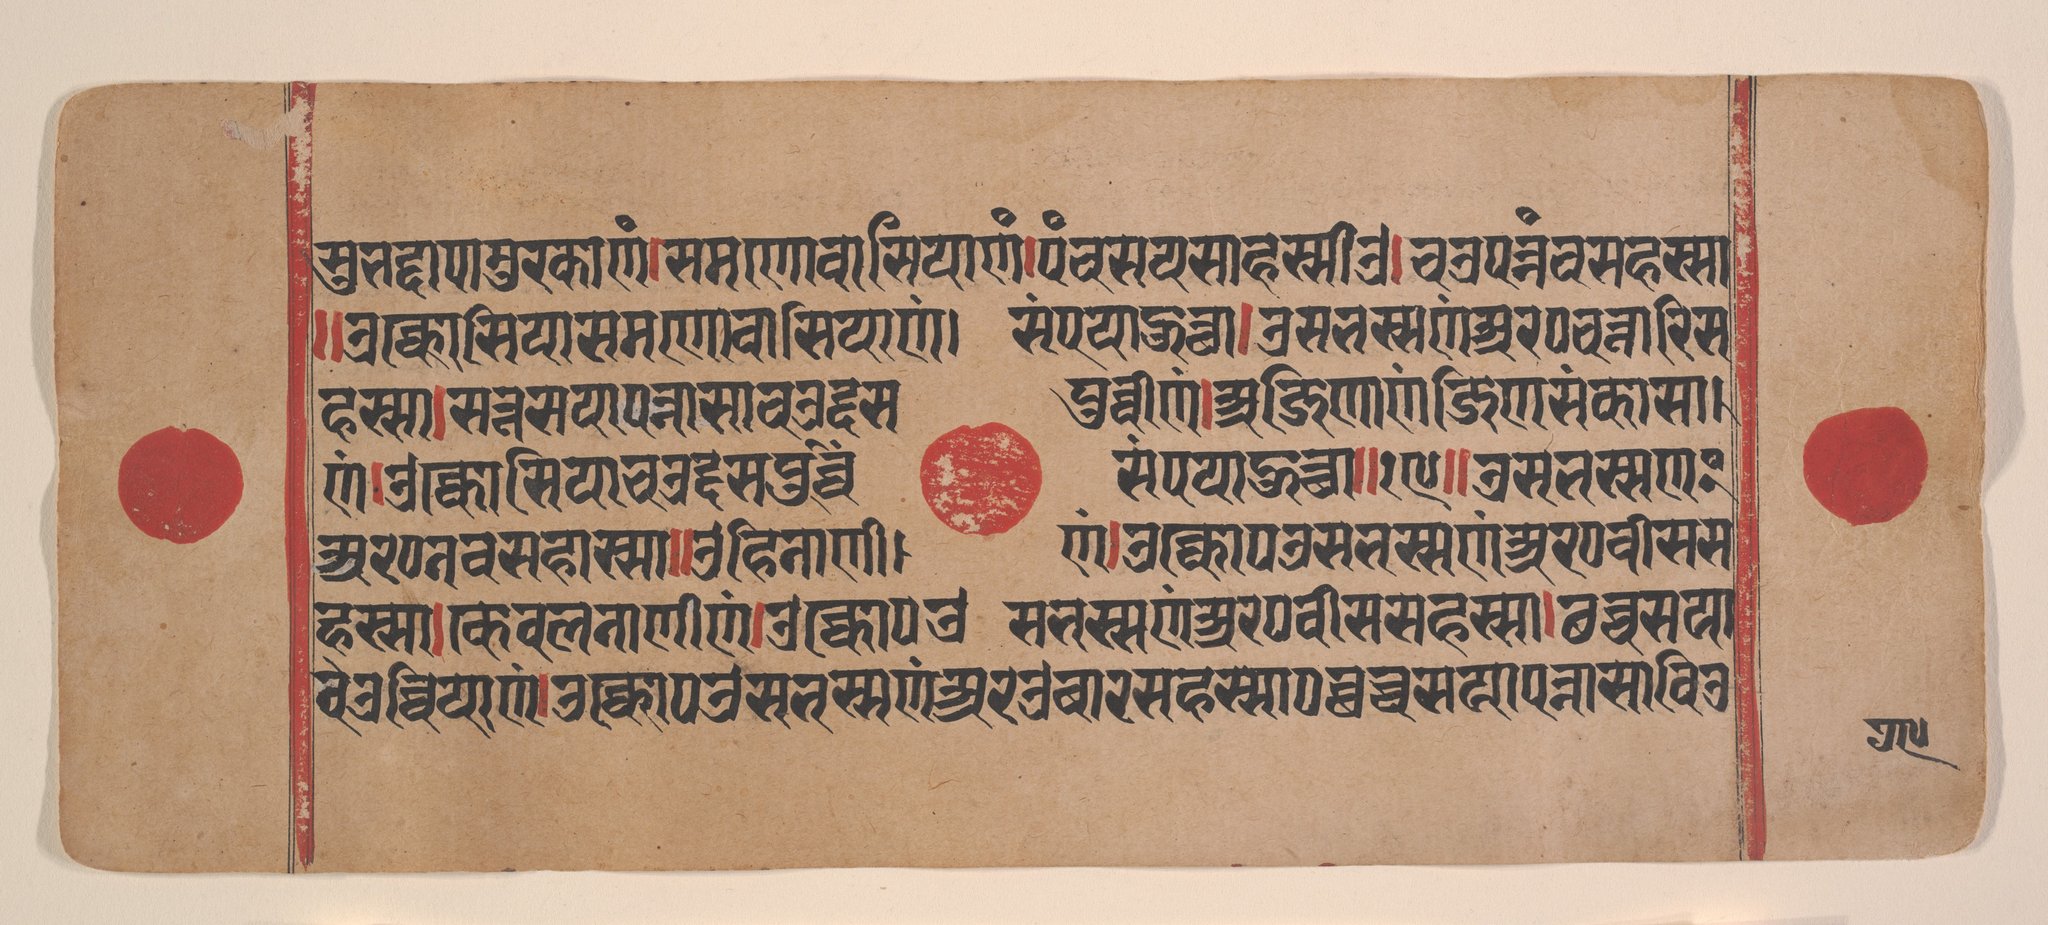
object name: folio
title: Page from a Dispersed Kalpa Sutra (Jain Book of Rituals)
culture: indian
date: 1401-1500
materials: gold, ink, paper, watercolor